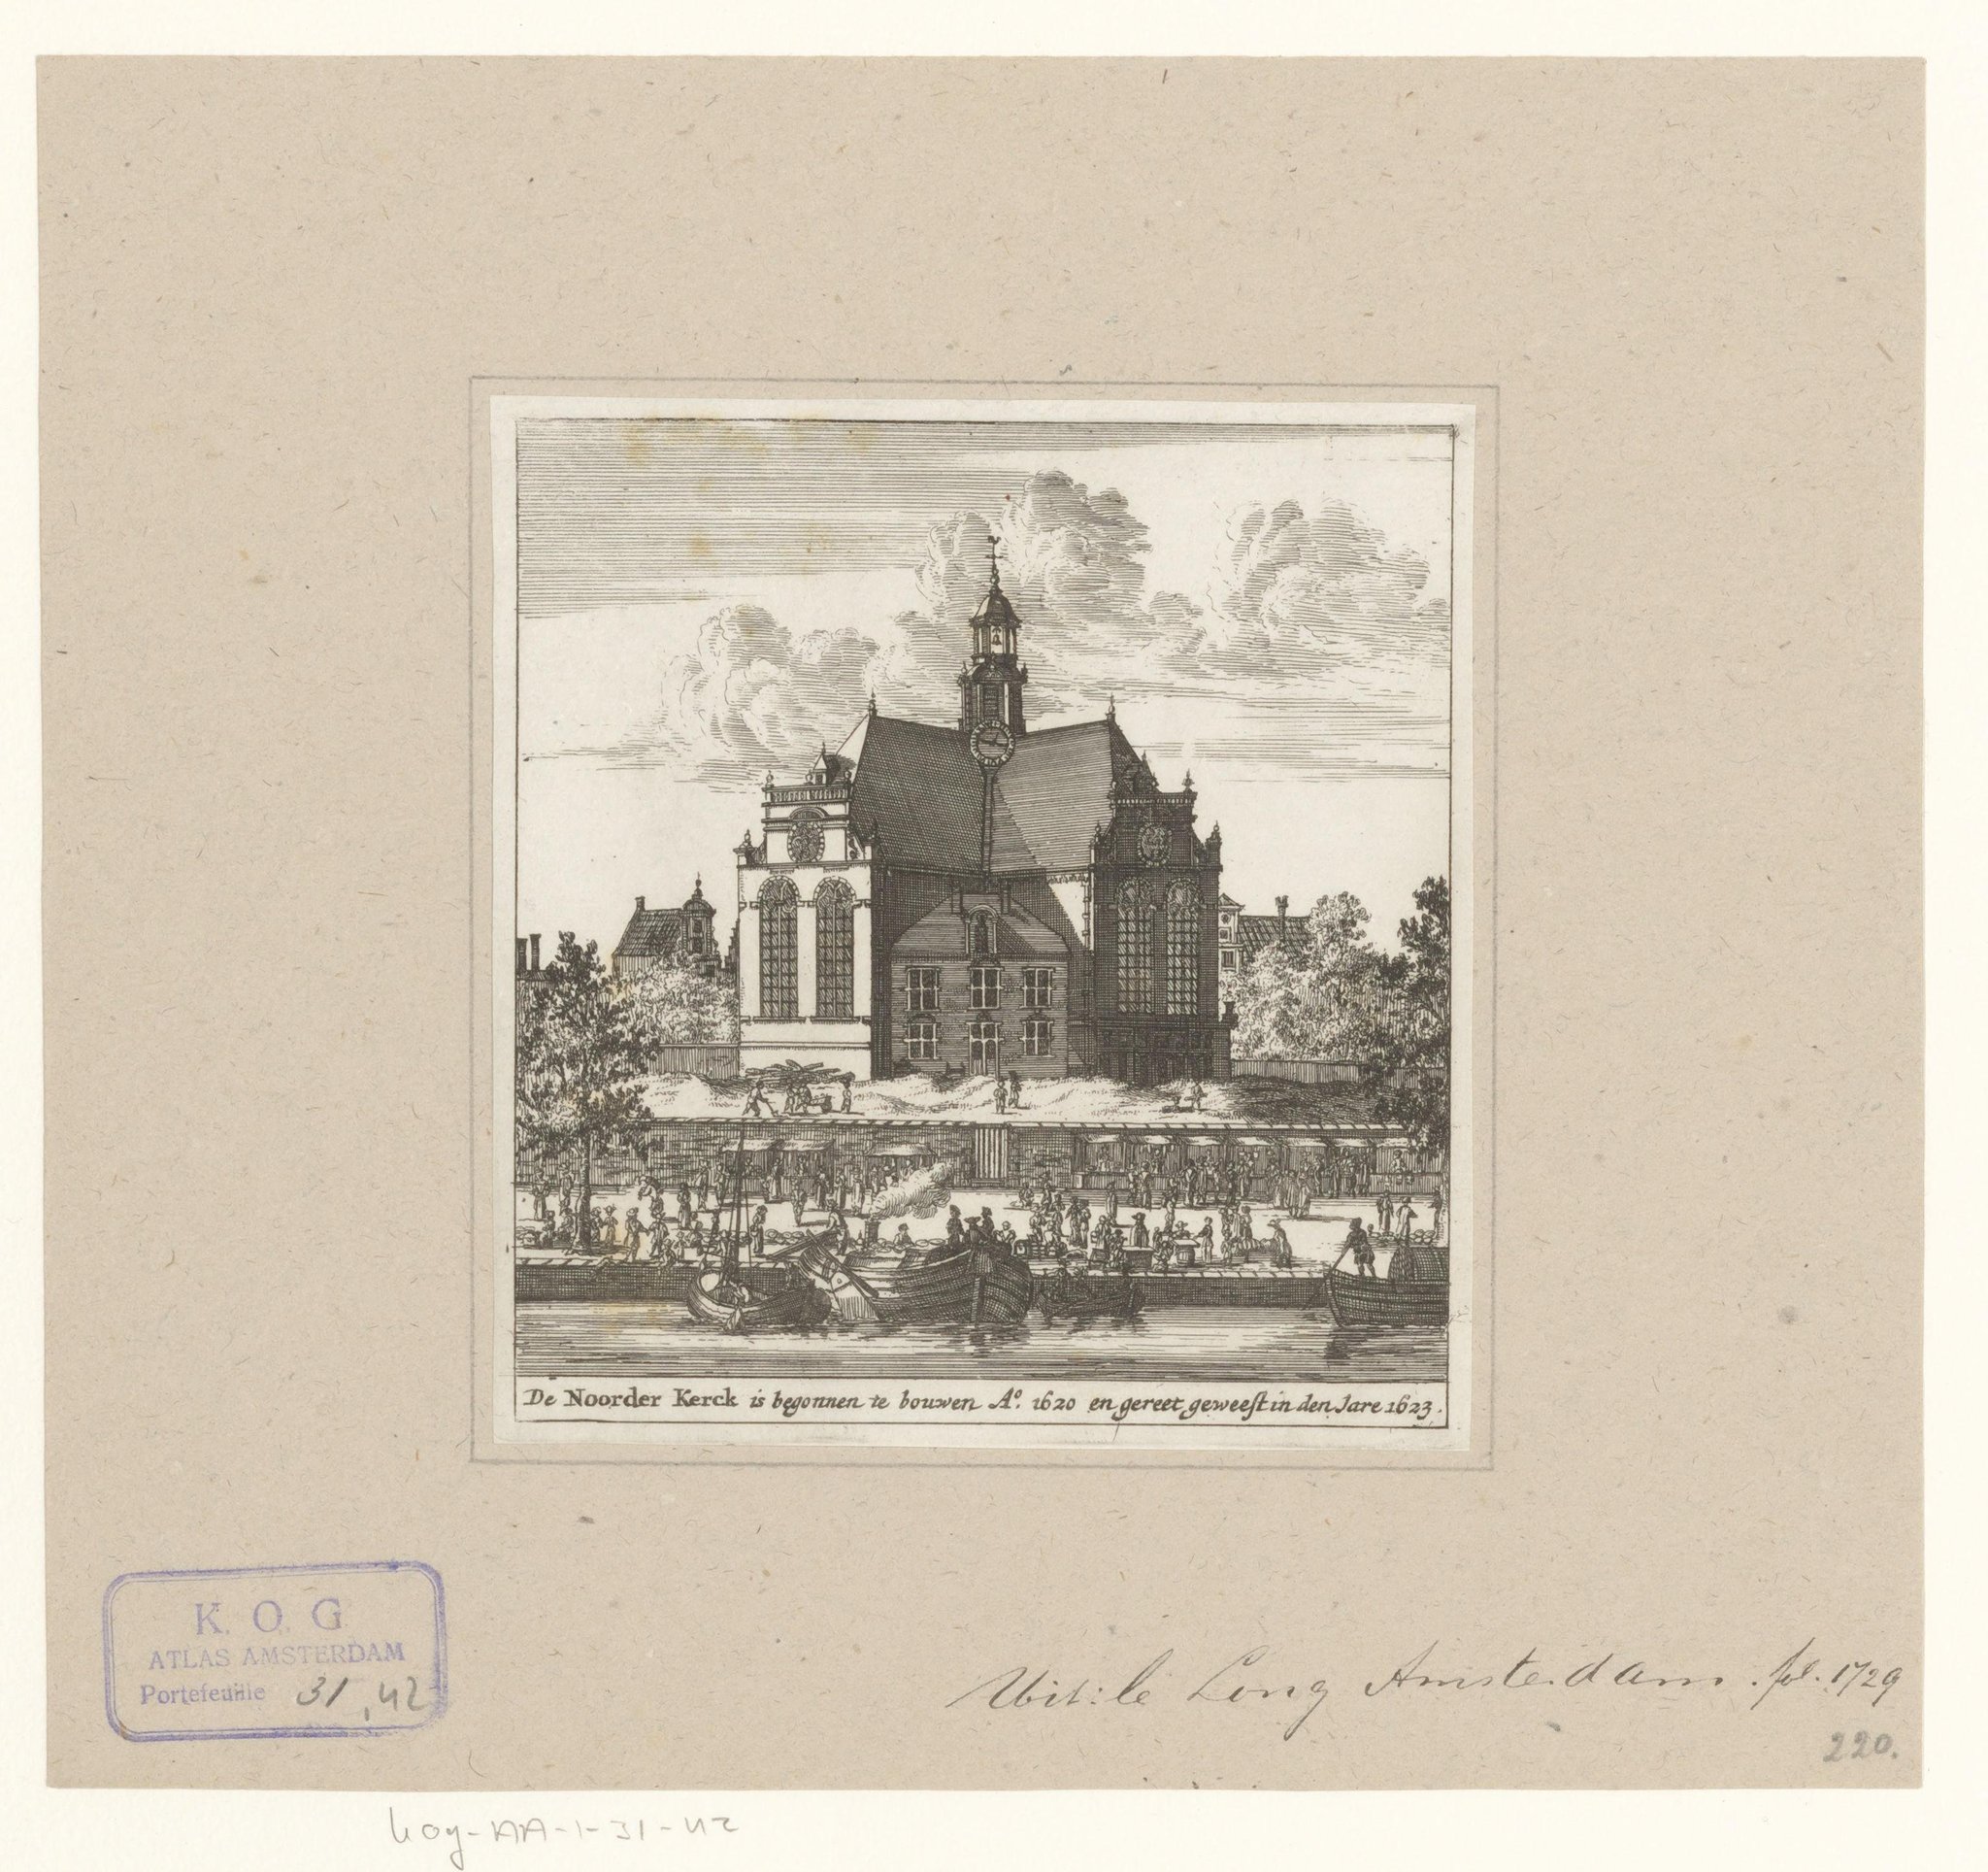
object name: print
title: Gezicht op de Noorderkerk te Amsterdam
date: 1729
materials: paper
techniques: engraving, etching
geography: amsterdam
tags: ships (in general), church (exterior), market, canals, waters (in city) (+ city(-scape) with figures, staffage)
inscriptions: collector's mark: Lugt 1641b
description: Prent mogelijk uit: Long, Isaac le. Historische beschryvinge van de reformatie der stadt Amsterdam (…). Amsterdam: Johannes van Septeren (I), 1729.